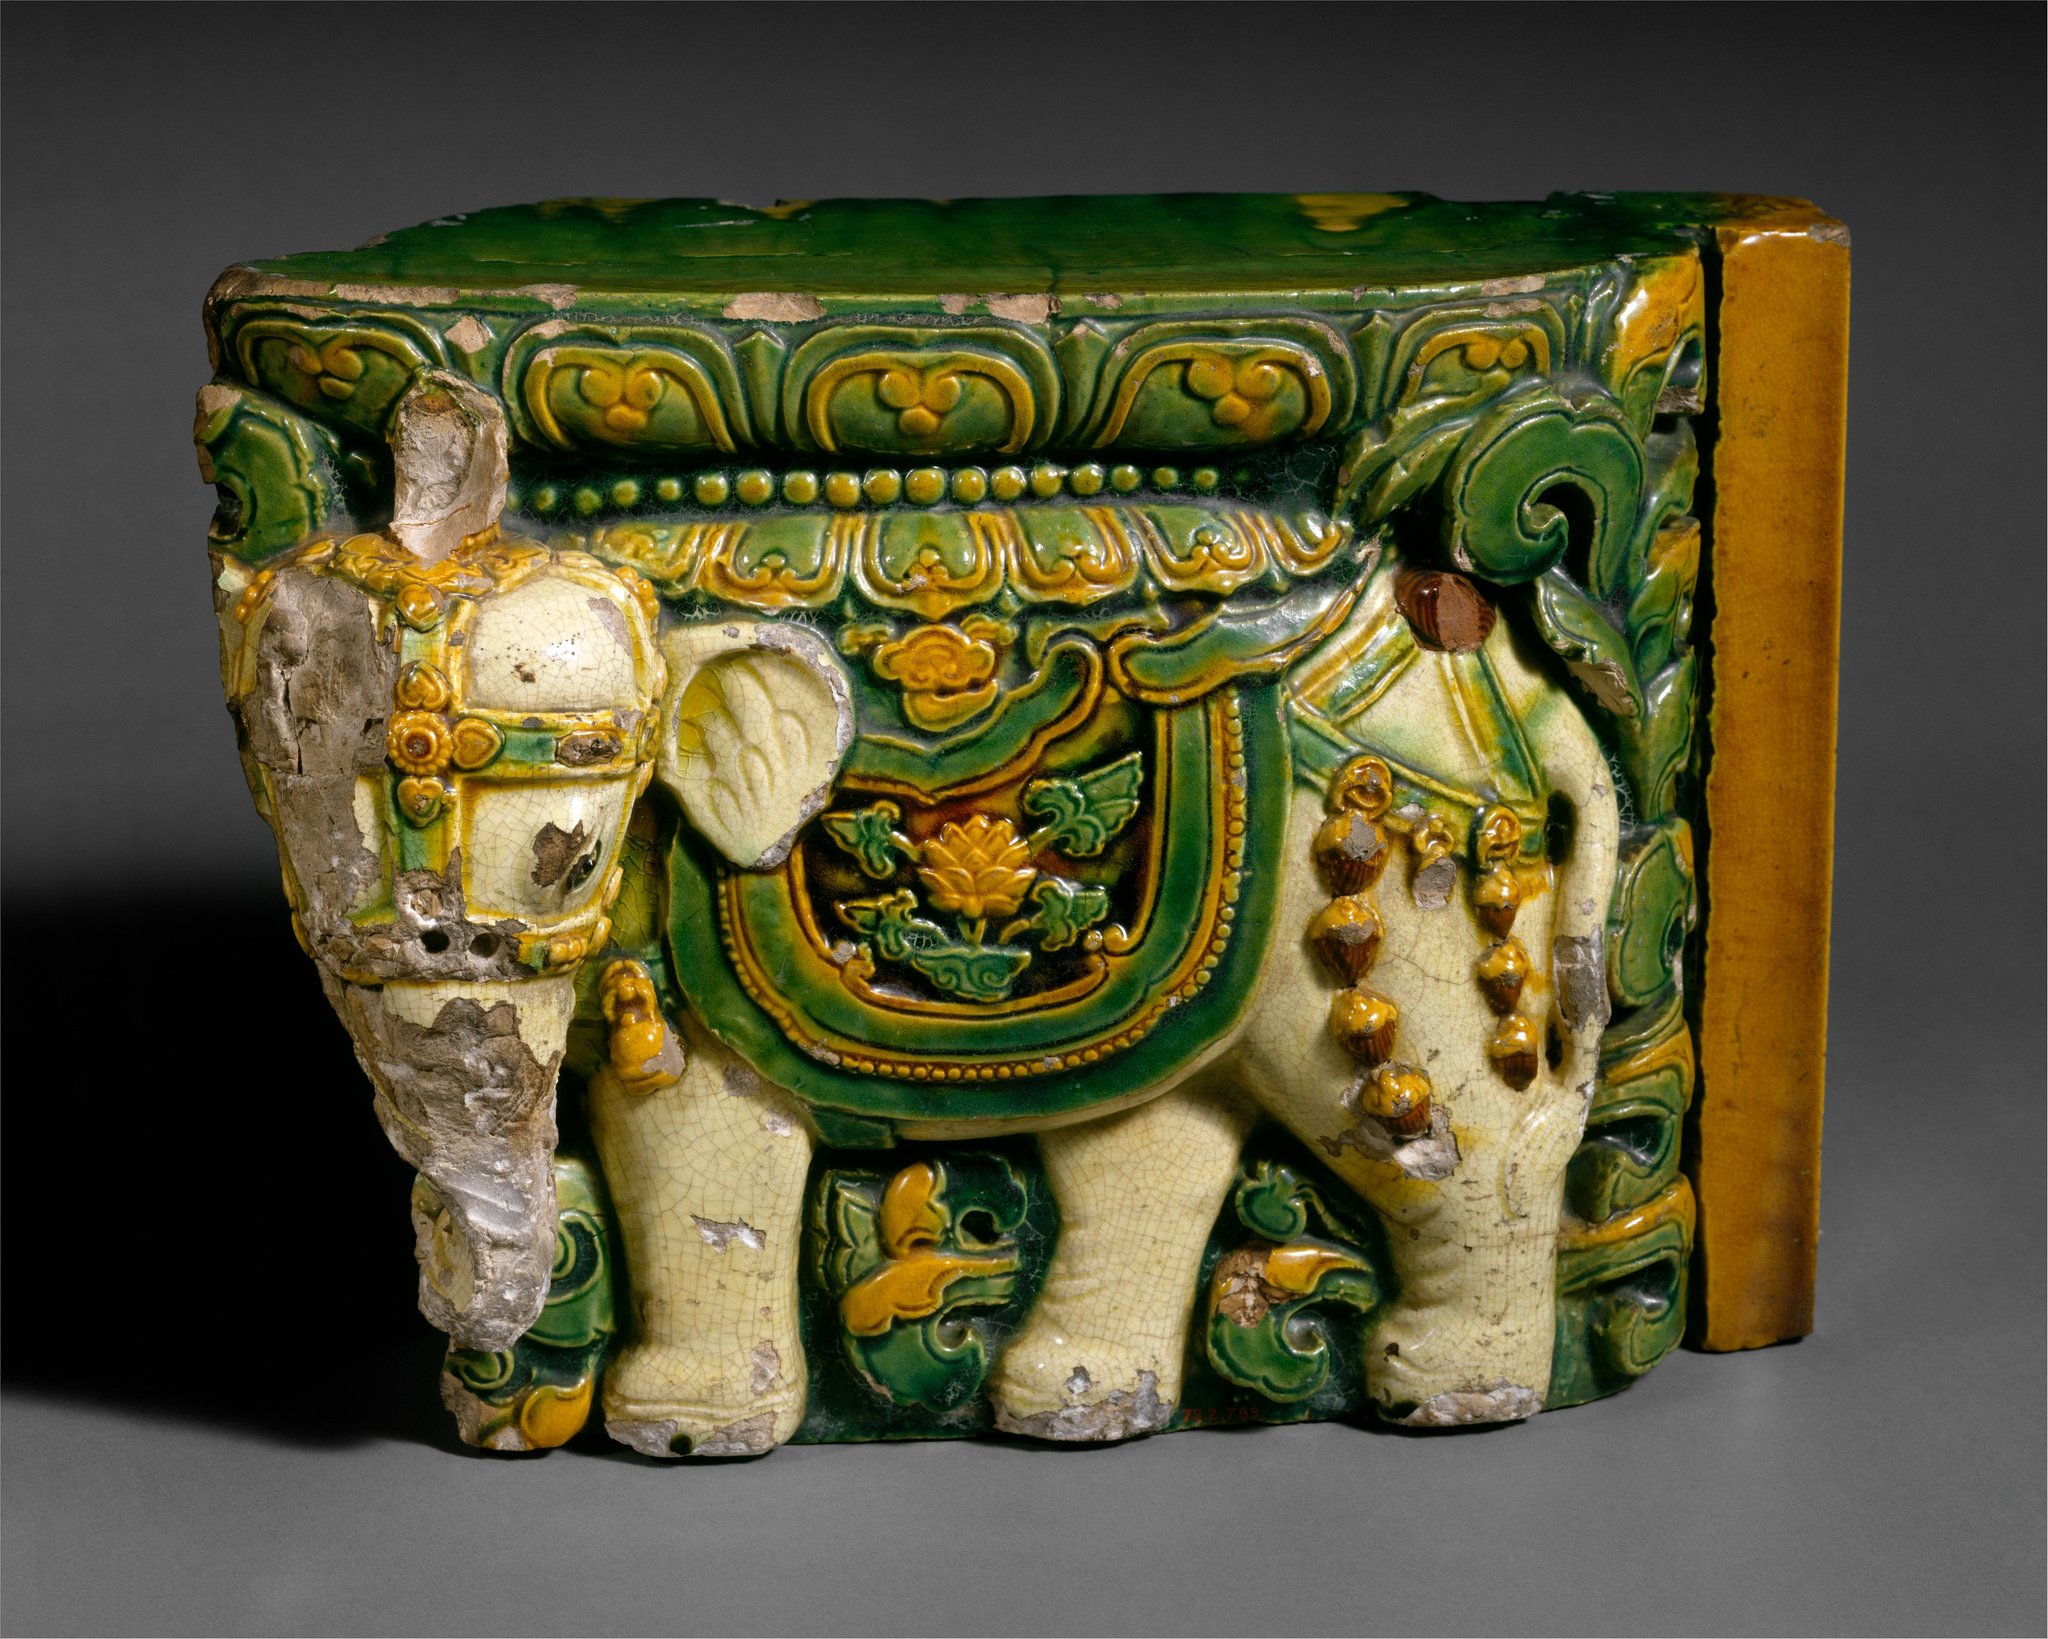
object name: tile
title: Door frame tile with elephant from the "Porcelain Pagoda"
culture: chinese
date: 1403-1424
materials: stoneware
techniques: glazing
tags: elephants